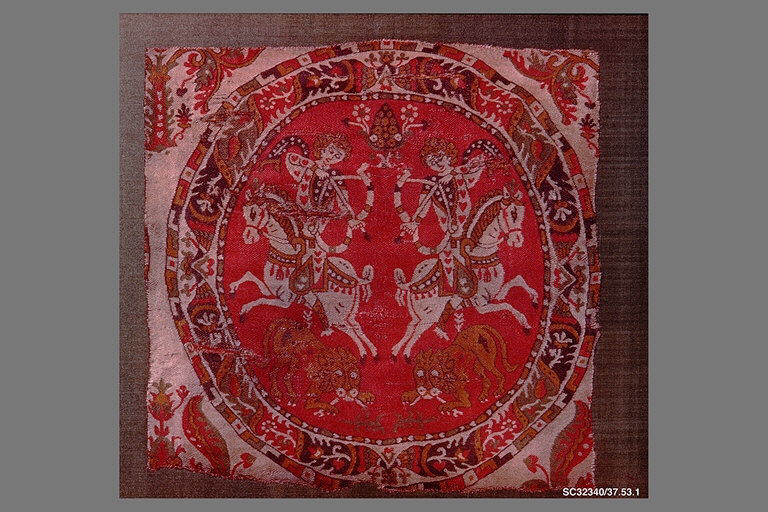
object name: textile fragment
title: Textile Fragment: Hunting Scene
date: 601-633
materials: silk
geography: syria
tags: bow and arrow,horses,lions